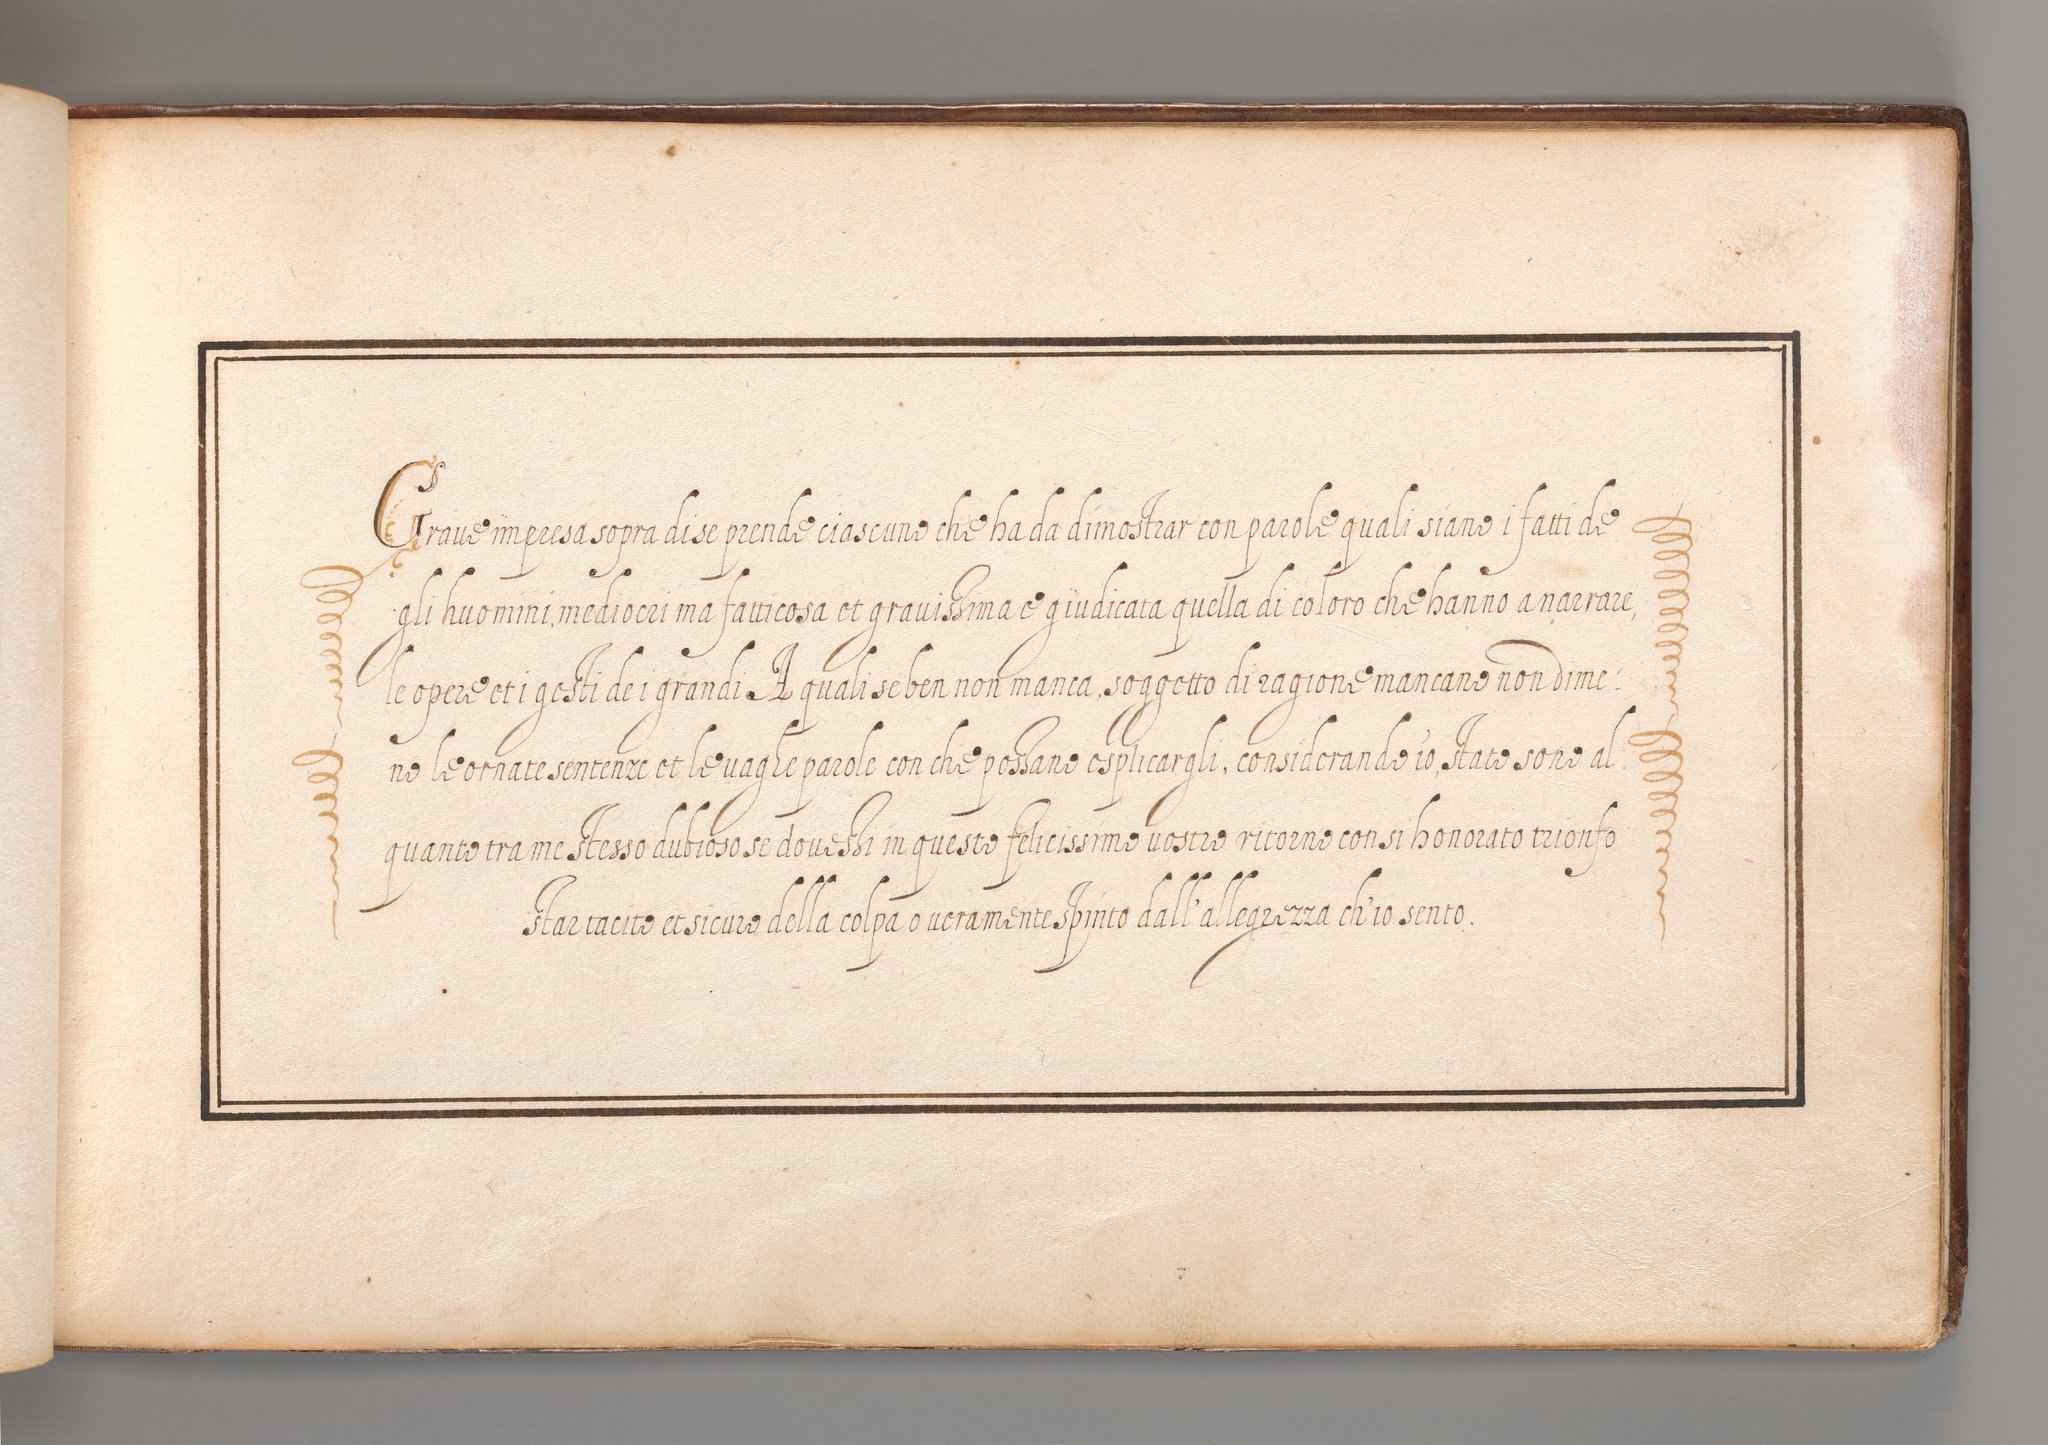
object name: album print ornament architecture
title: Calligraphic Exercise in Italian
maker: Anonymous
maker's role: artist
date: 1601-1633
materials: ink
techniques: pen